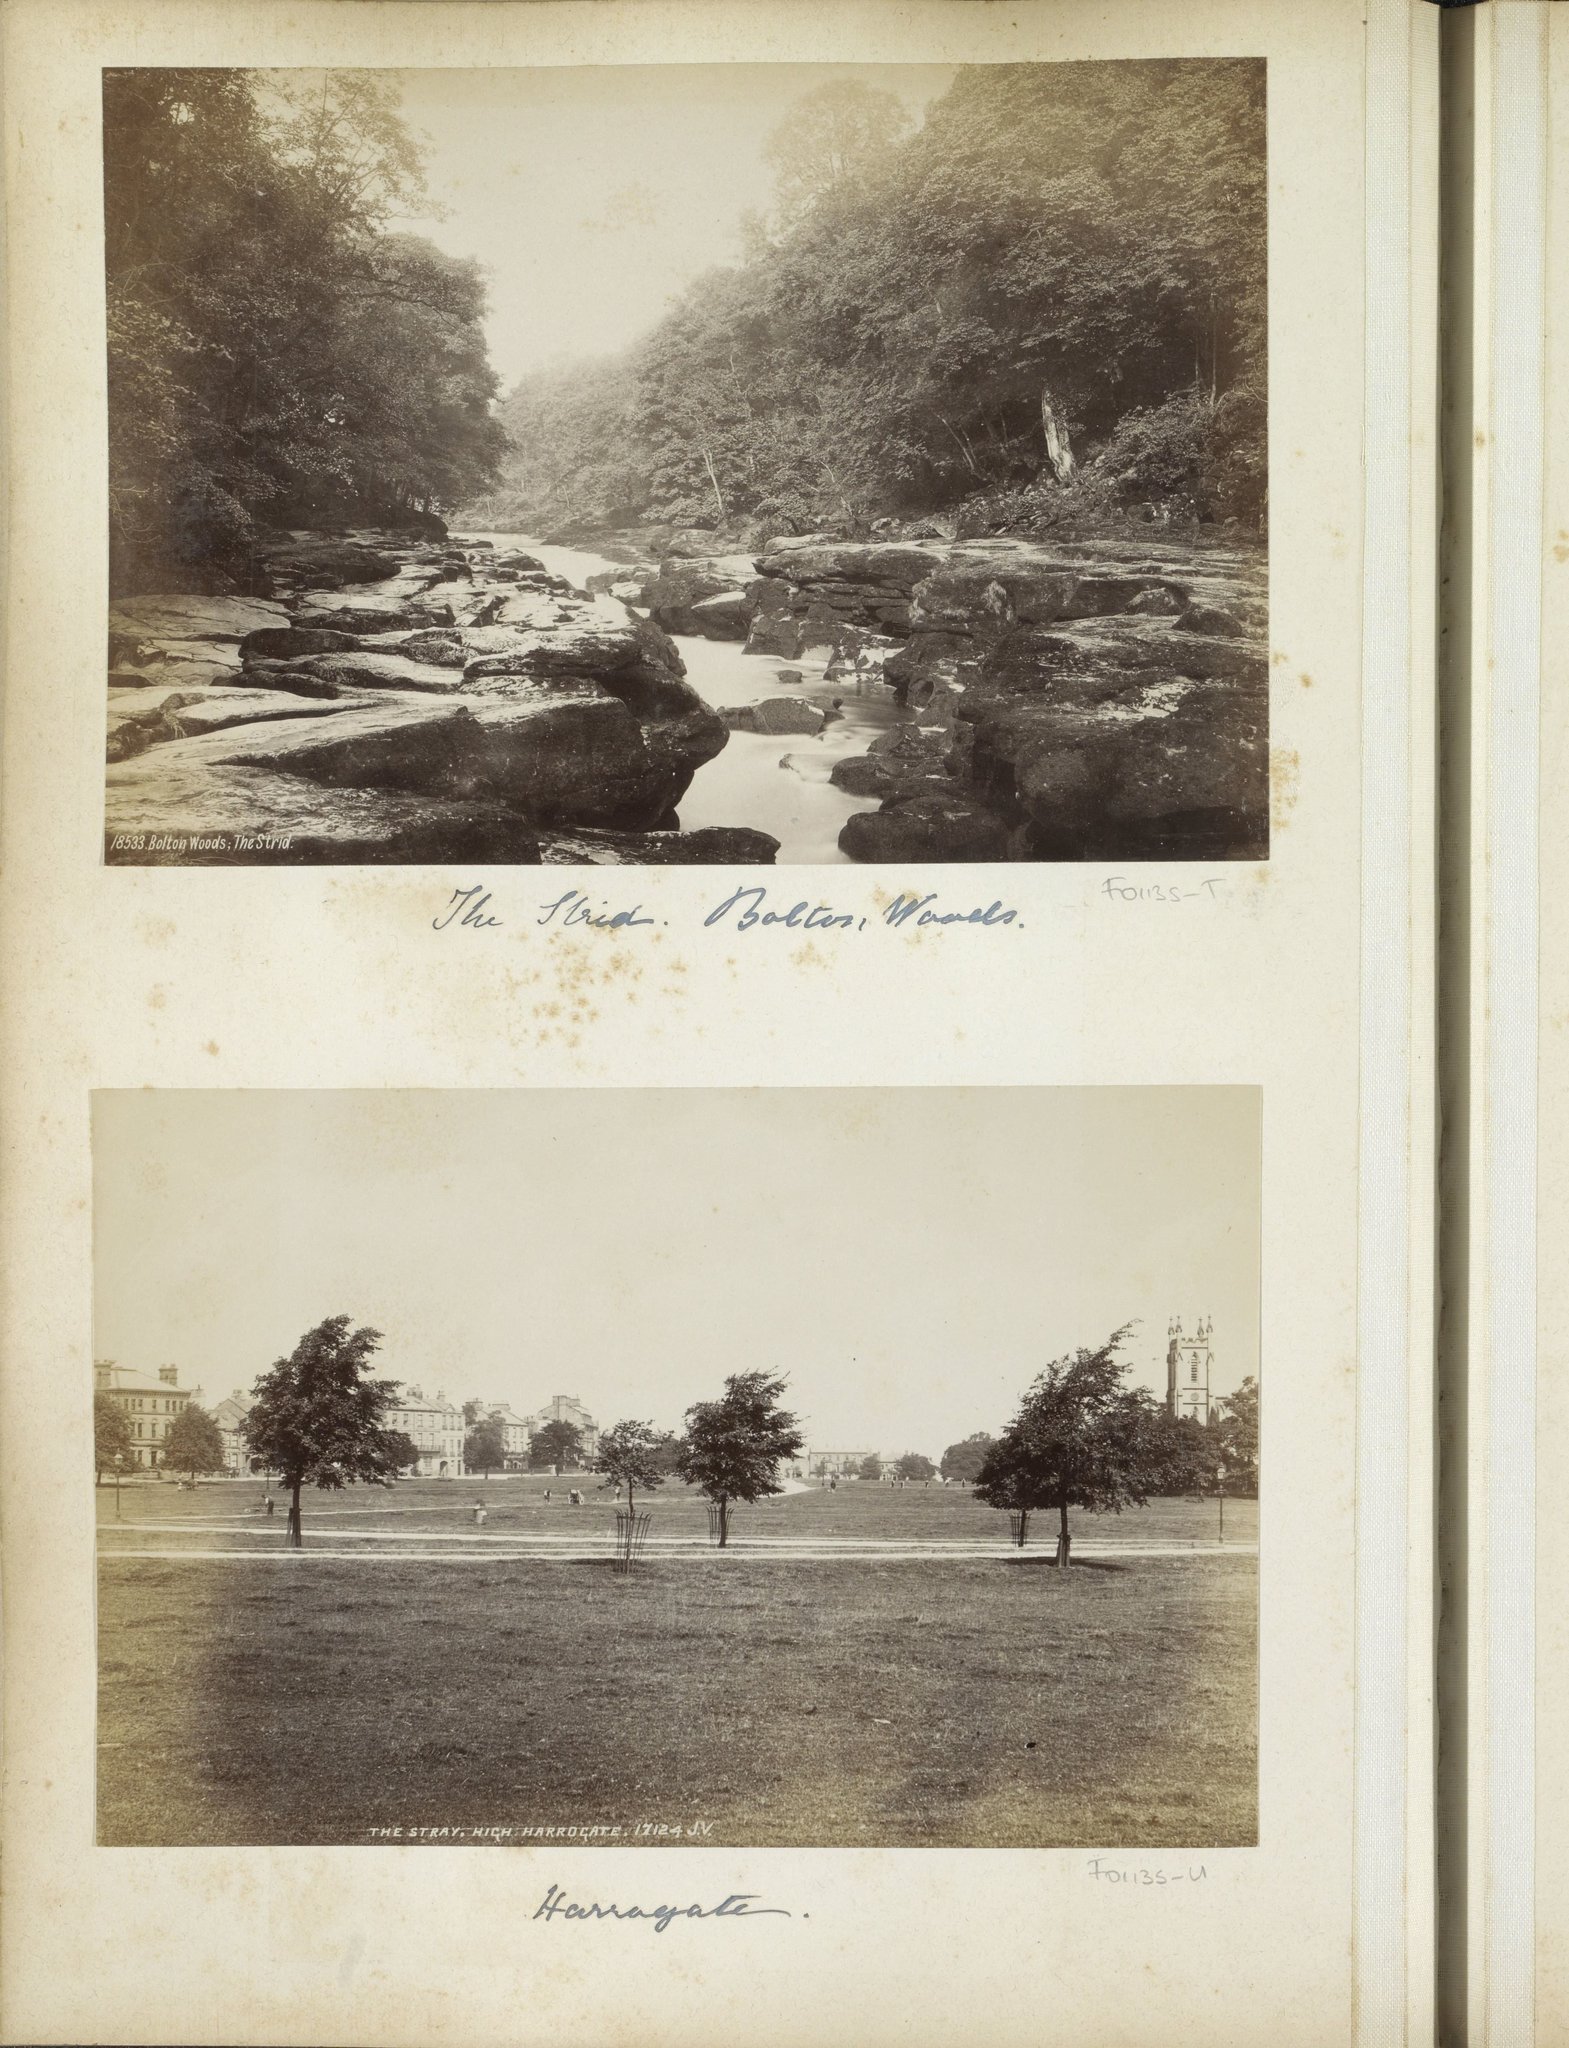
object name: photograph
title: Bolton Woods; The Strid.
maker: Anonymous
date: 1898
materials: paper, photographic support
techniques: albumen print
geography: bolton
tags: river (+ landscape with figures, staffage), boulder, stone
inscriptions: negative number: ‘18533’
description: Onderdeel van Reisalbum met foto's van bezienswaardigheden in Engeland en Frankrijk.